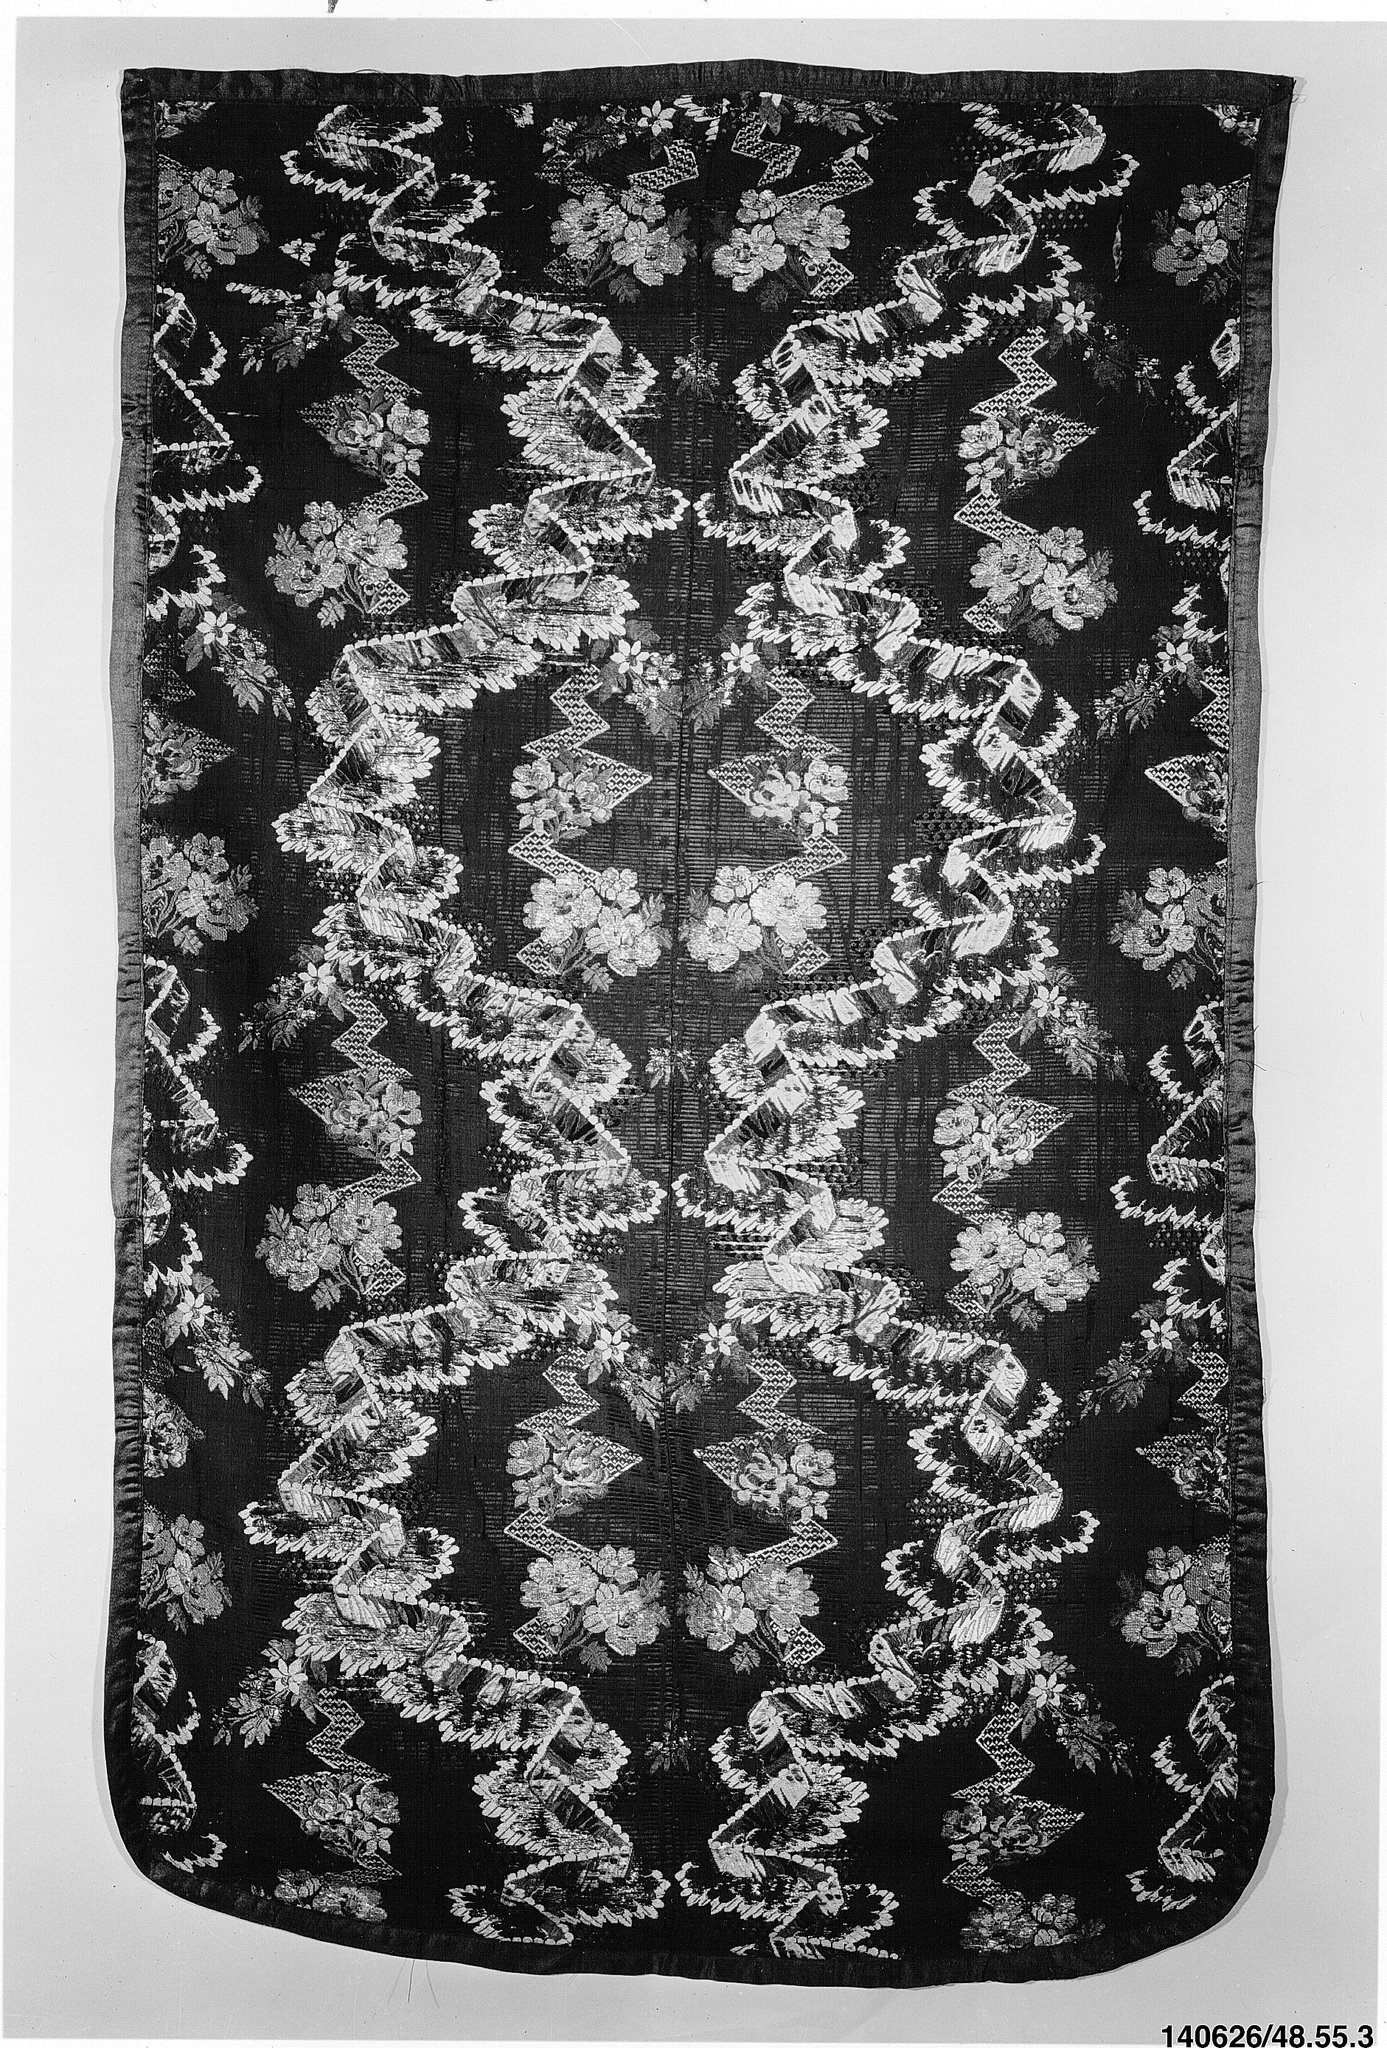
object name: piece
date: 1750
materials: metal thread, silk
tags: flowers